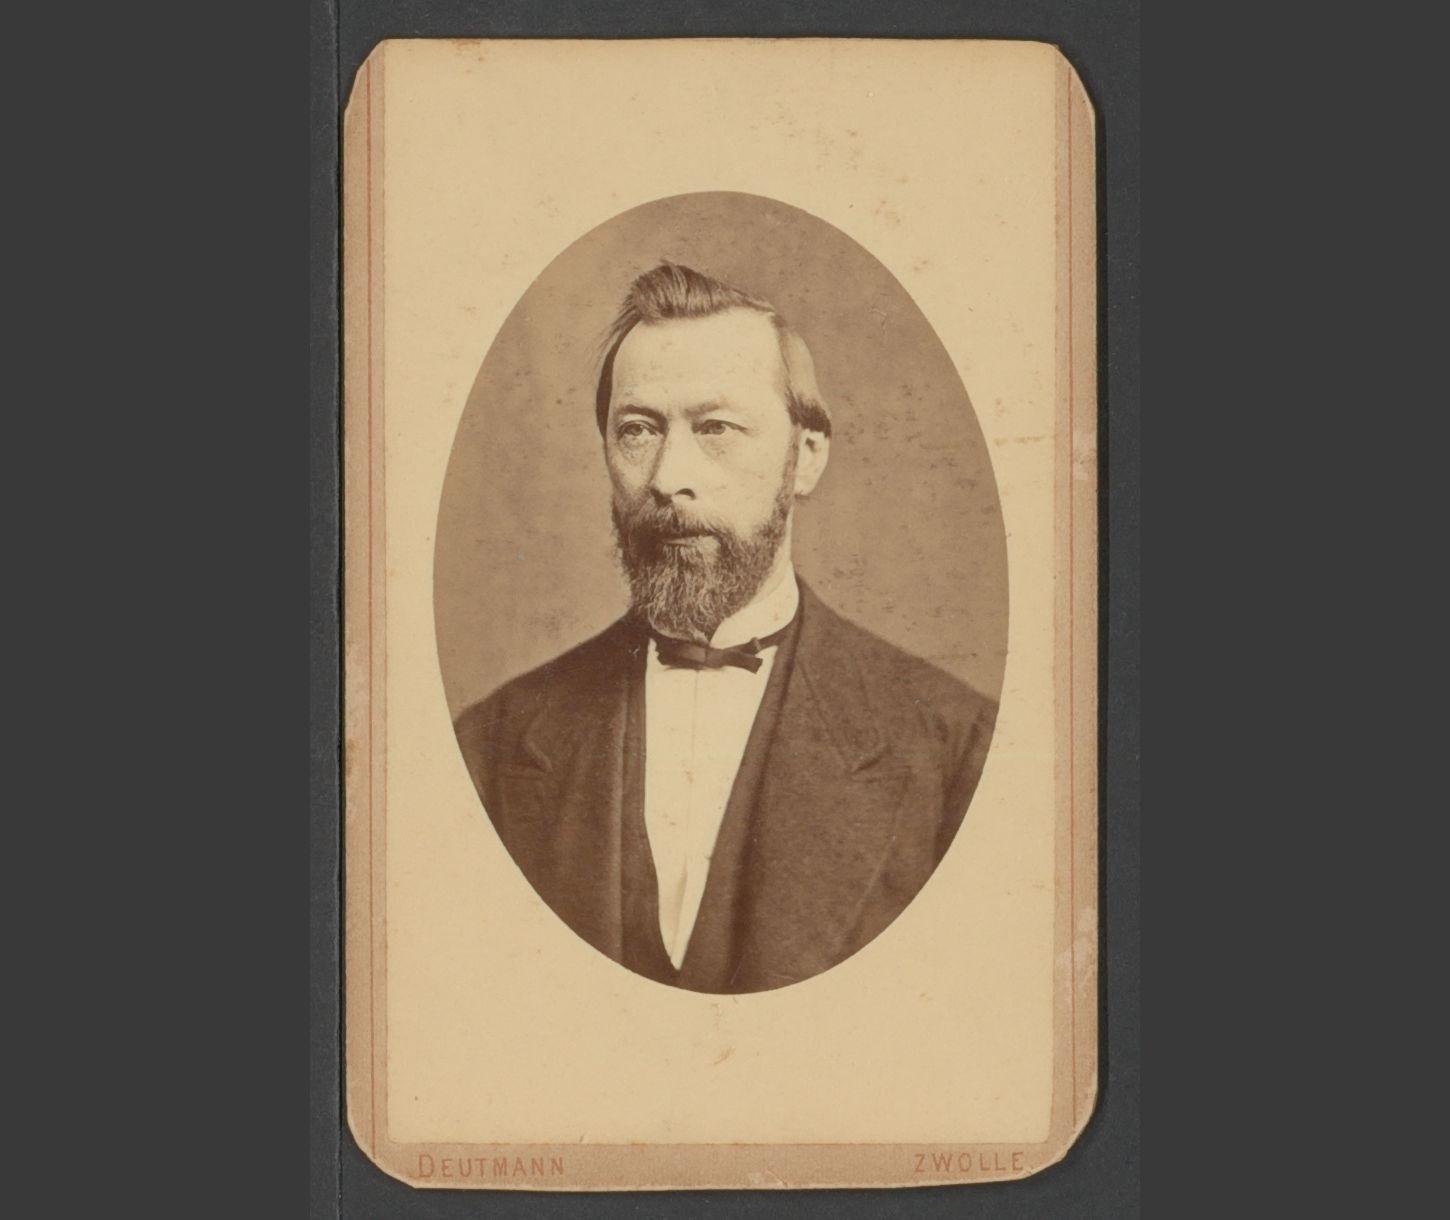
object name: photograph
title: Portret van J. Gratama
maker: franz wilhelm heinrich deutmann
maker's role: fotograaf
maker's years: 1840-1906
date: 1865-1883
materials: cardboard, paper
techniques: albumen print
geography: zwolle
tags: j. gratama, historical persons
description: Onderwerpsrubrieken binnen de Atlas Zeden en Gewoonten: Schoone kunsten, Pennekunst.